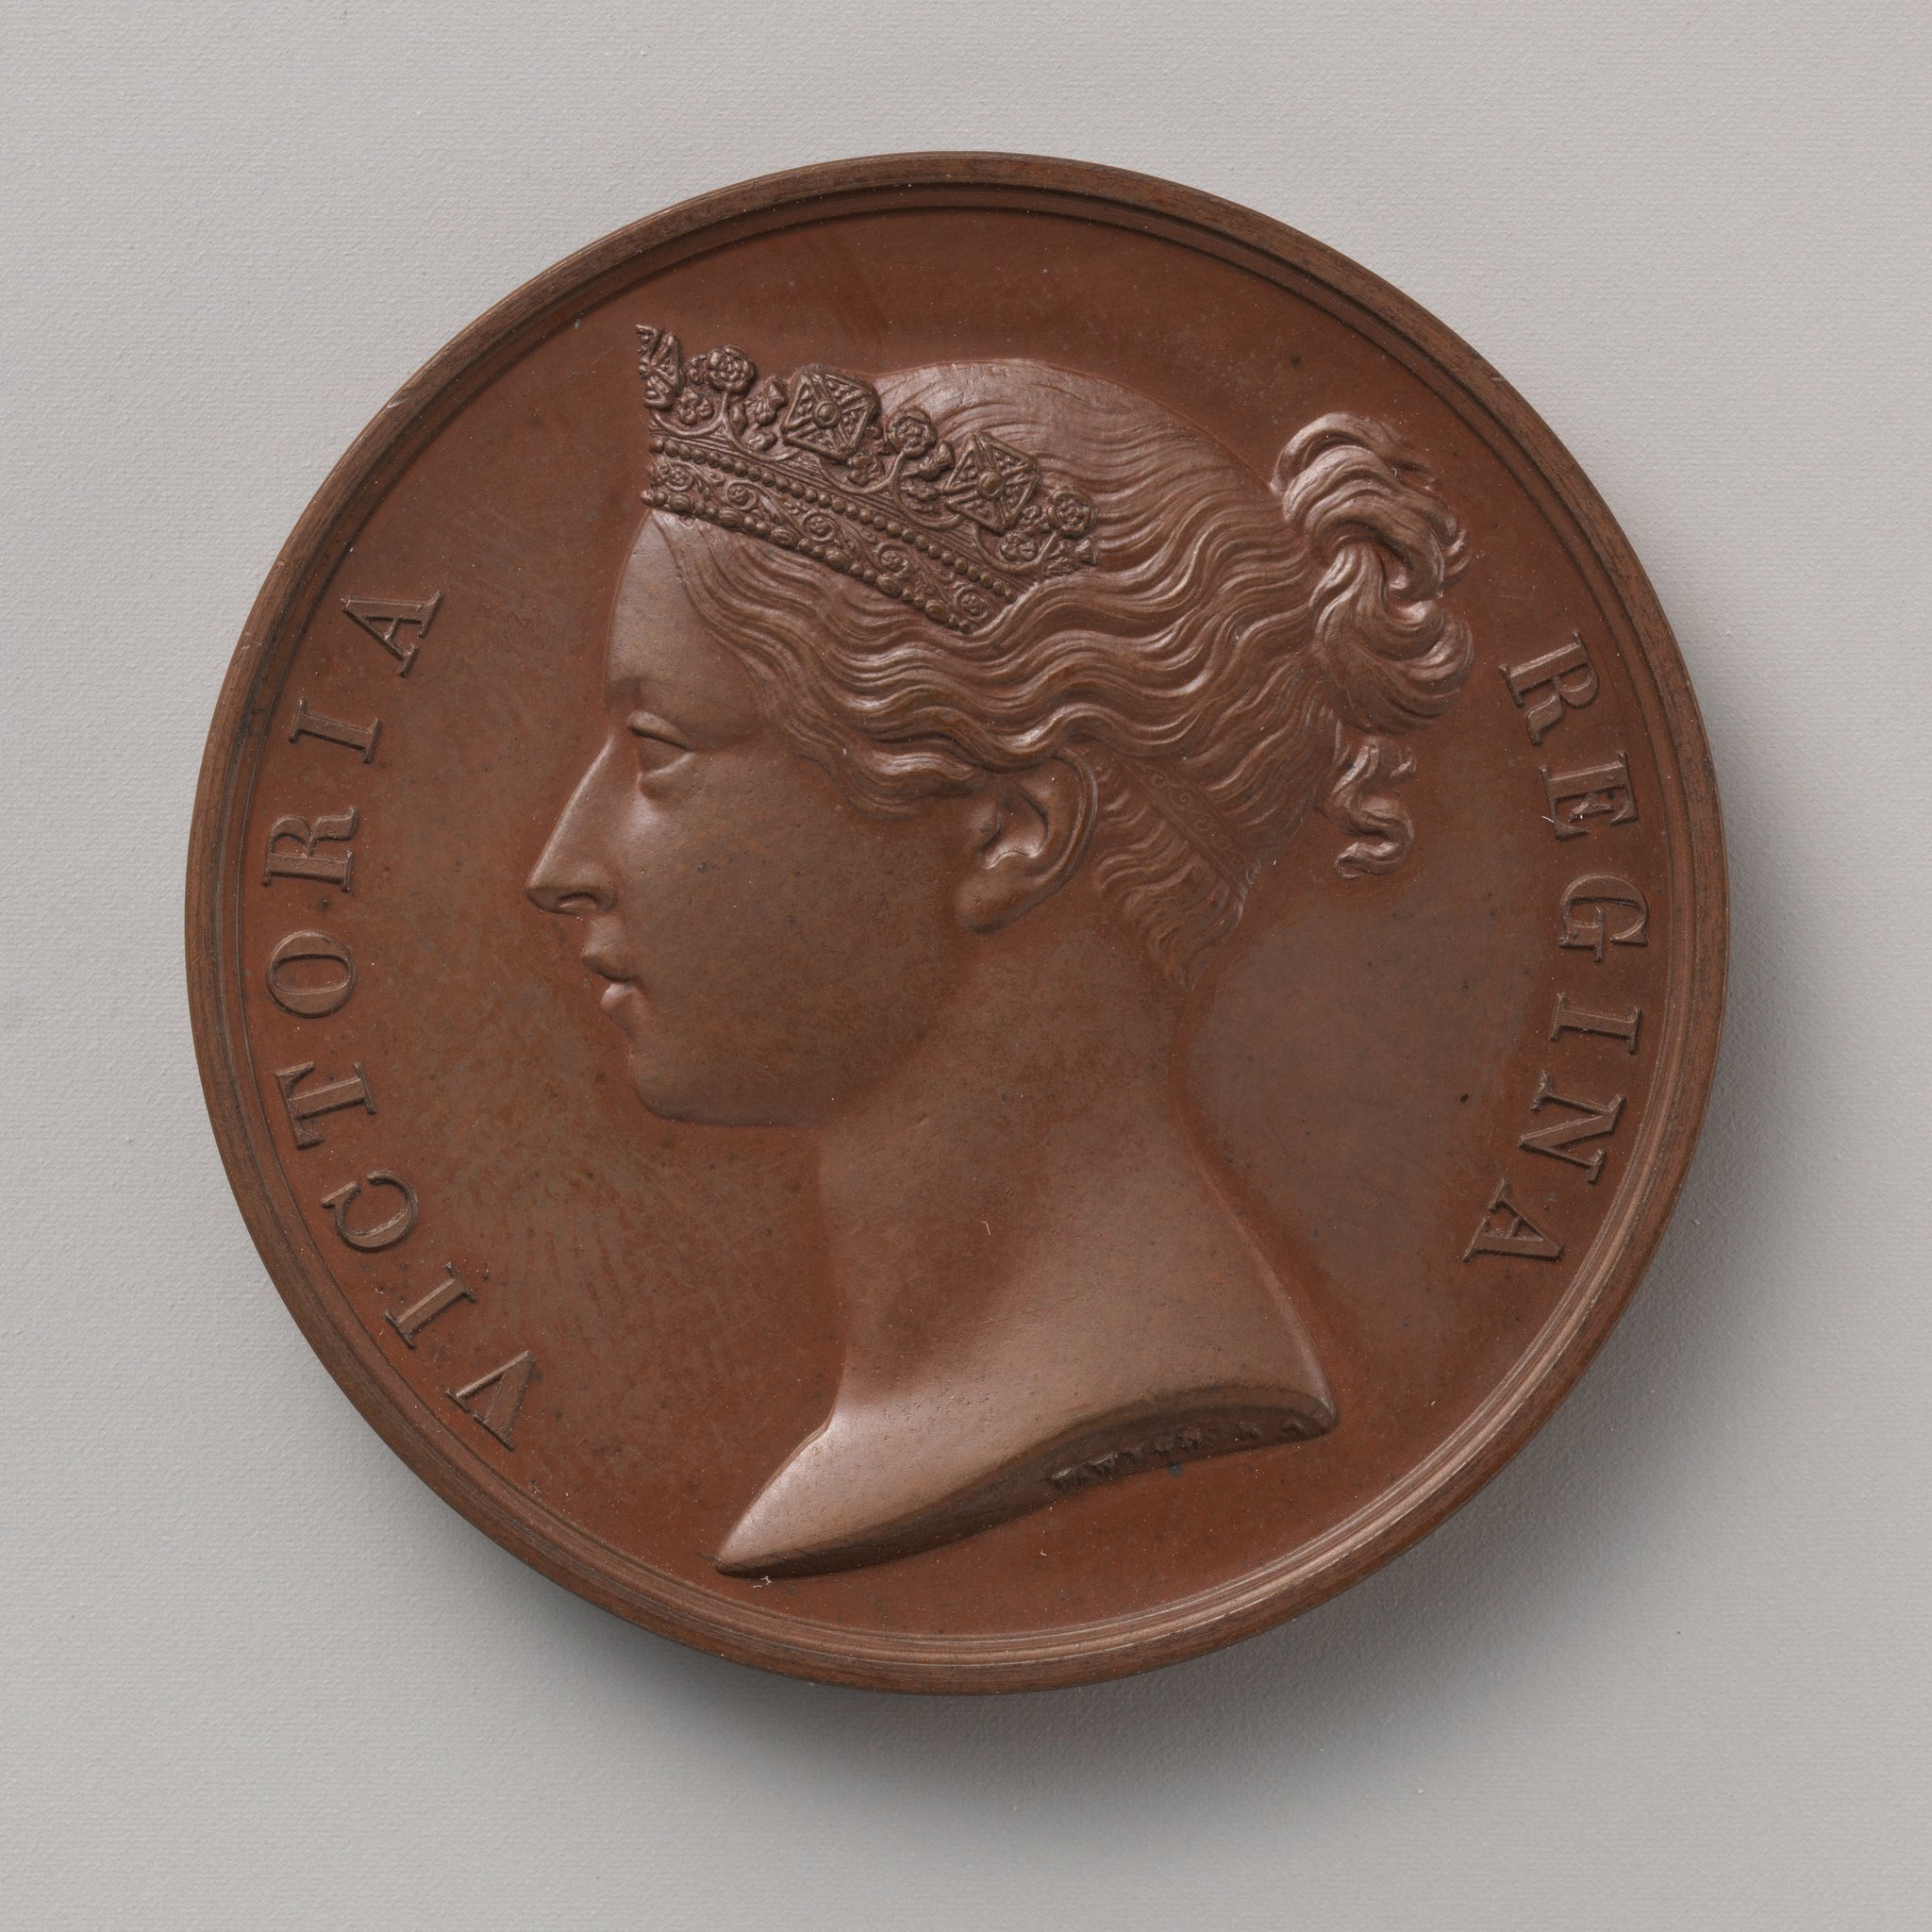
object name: medal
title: The Cape Medal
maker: william wyon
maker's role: artist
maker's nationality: british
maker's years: 1795-1851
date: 1853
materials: bronze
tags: profiles,lions